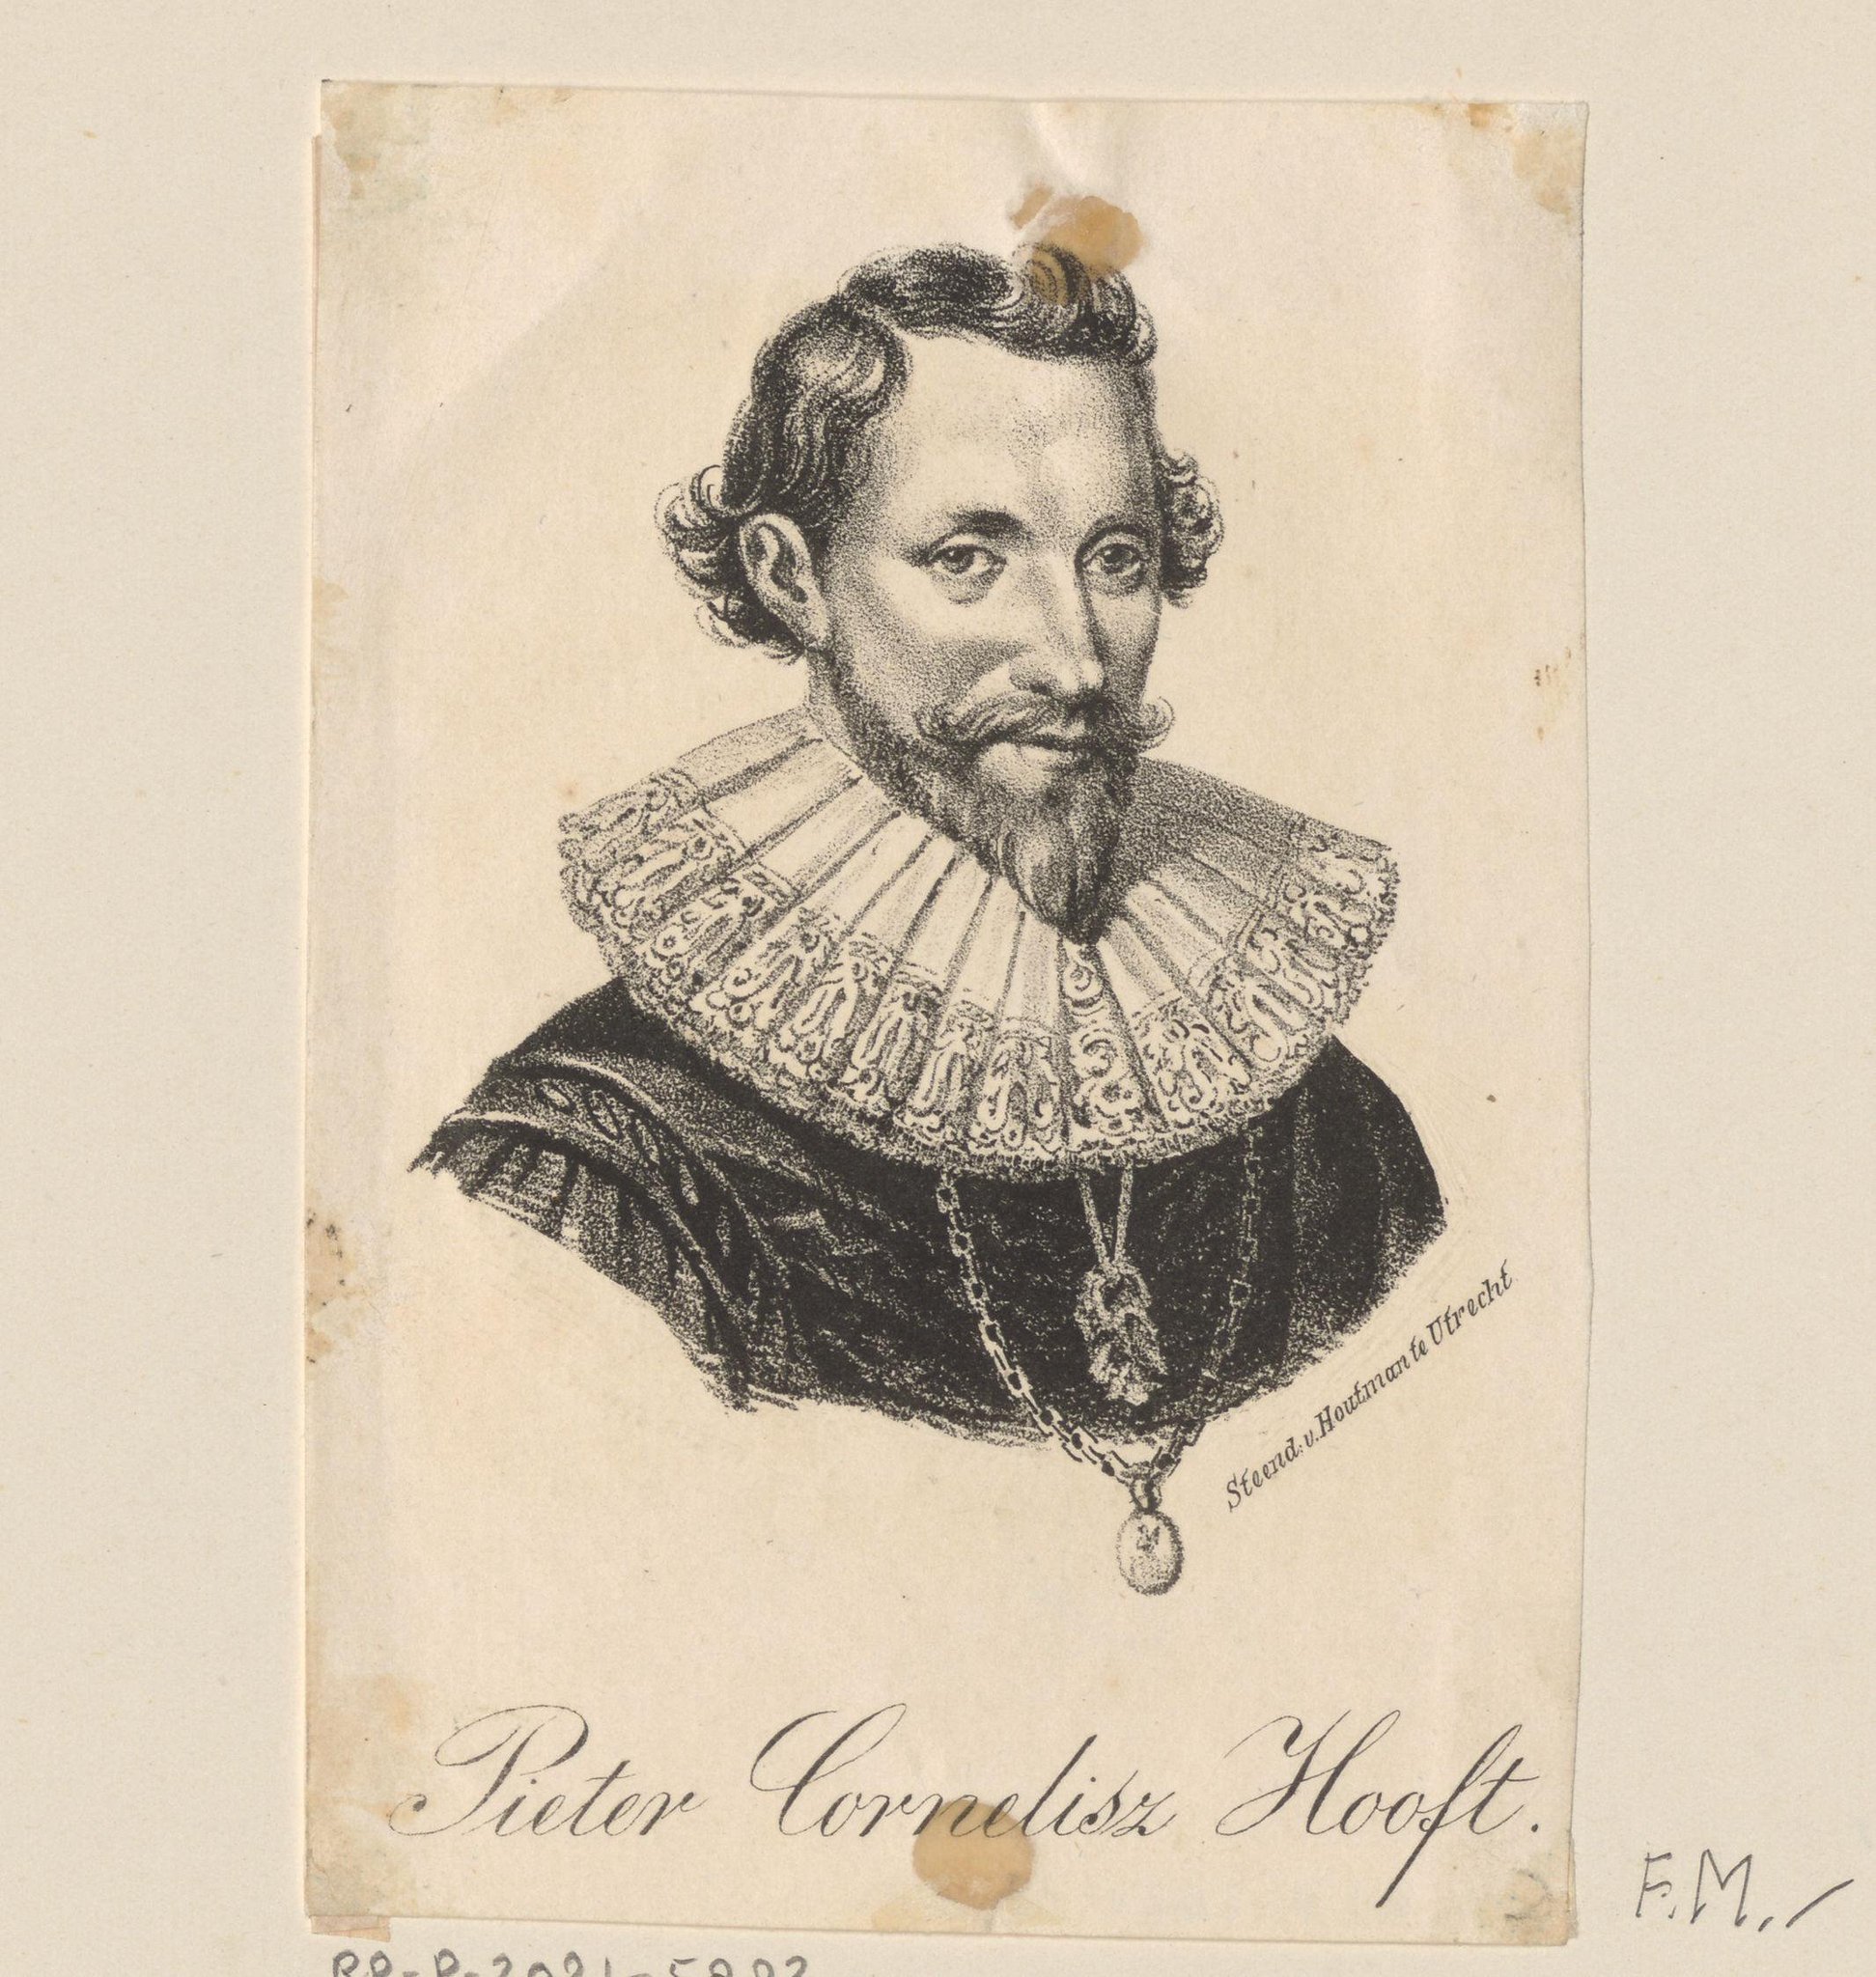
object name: print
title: Portret van Pieter Corneliszoon Hooft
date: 1850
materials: paper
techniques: lithograph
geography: utrecht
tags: amsterdam, the hague, pieter corneliszoon hooft, historical persons, writer, poet, author